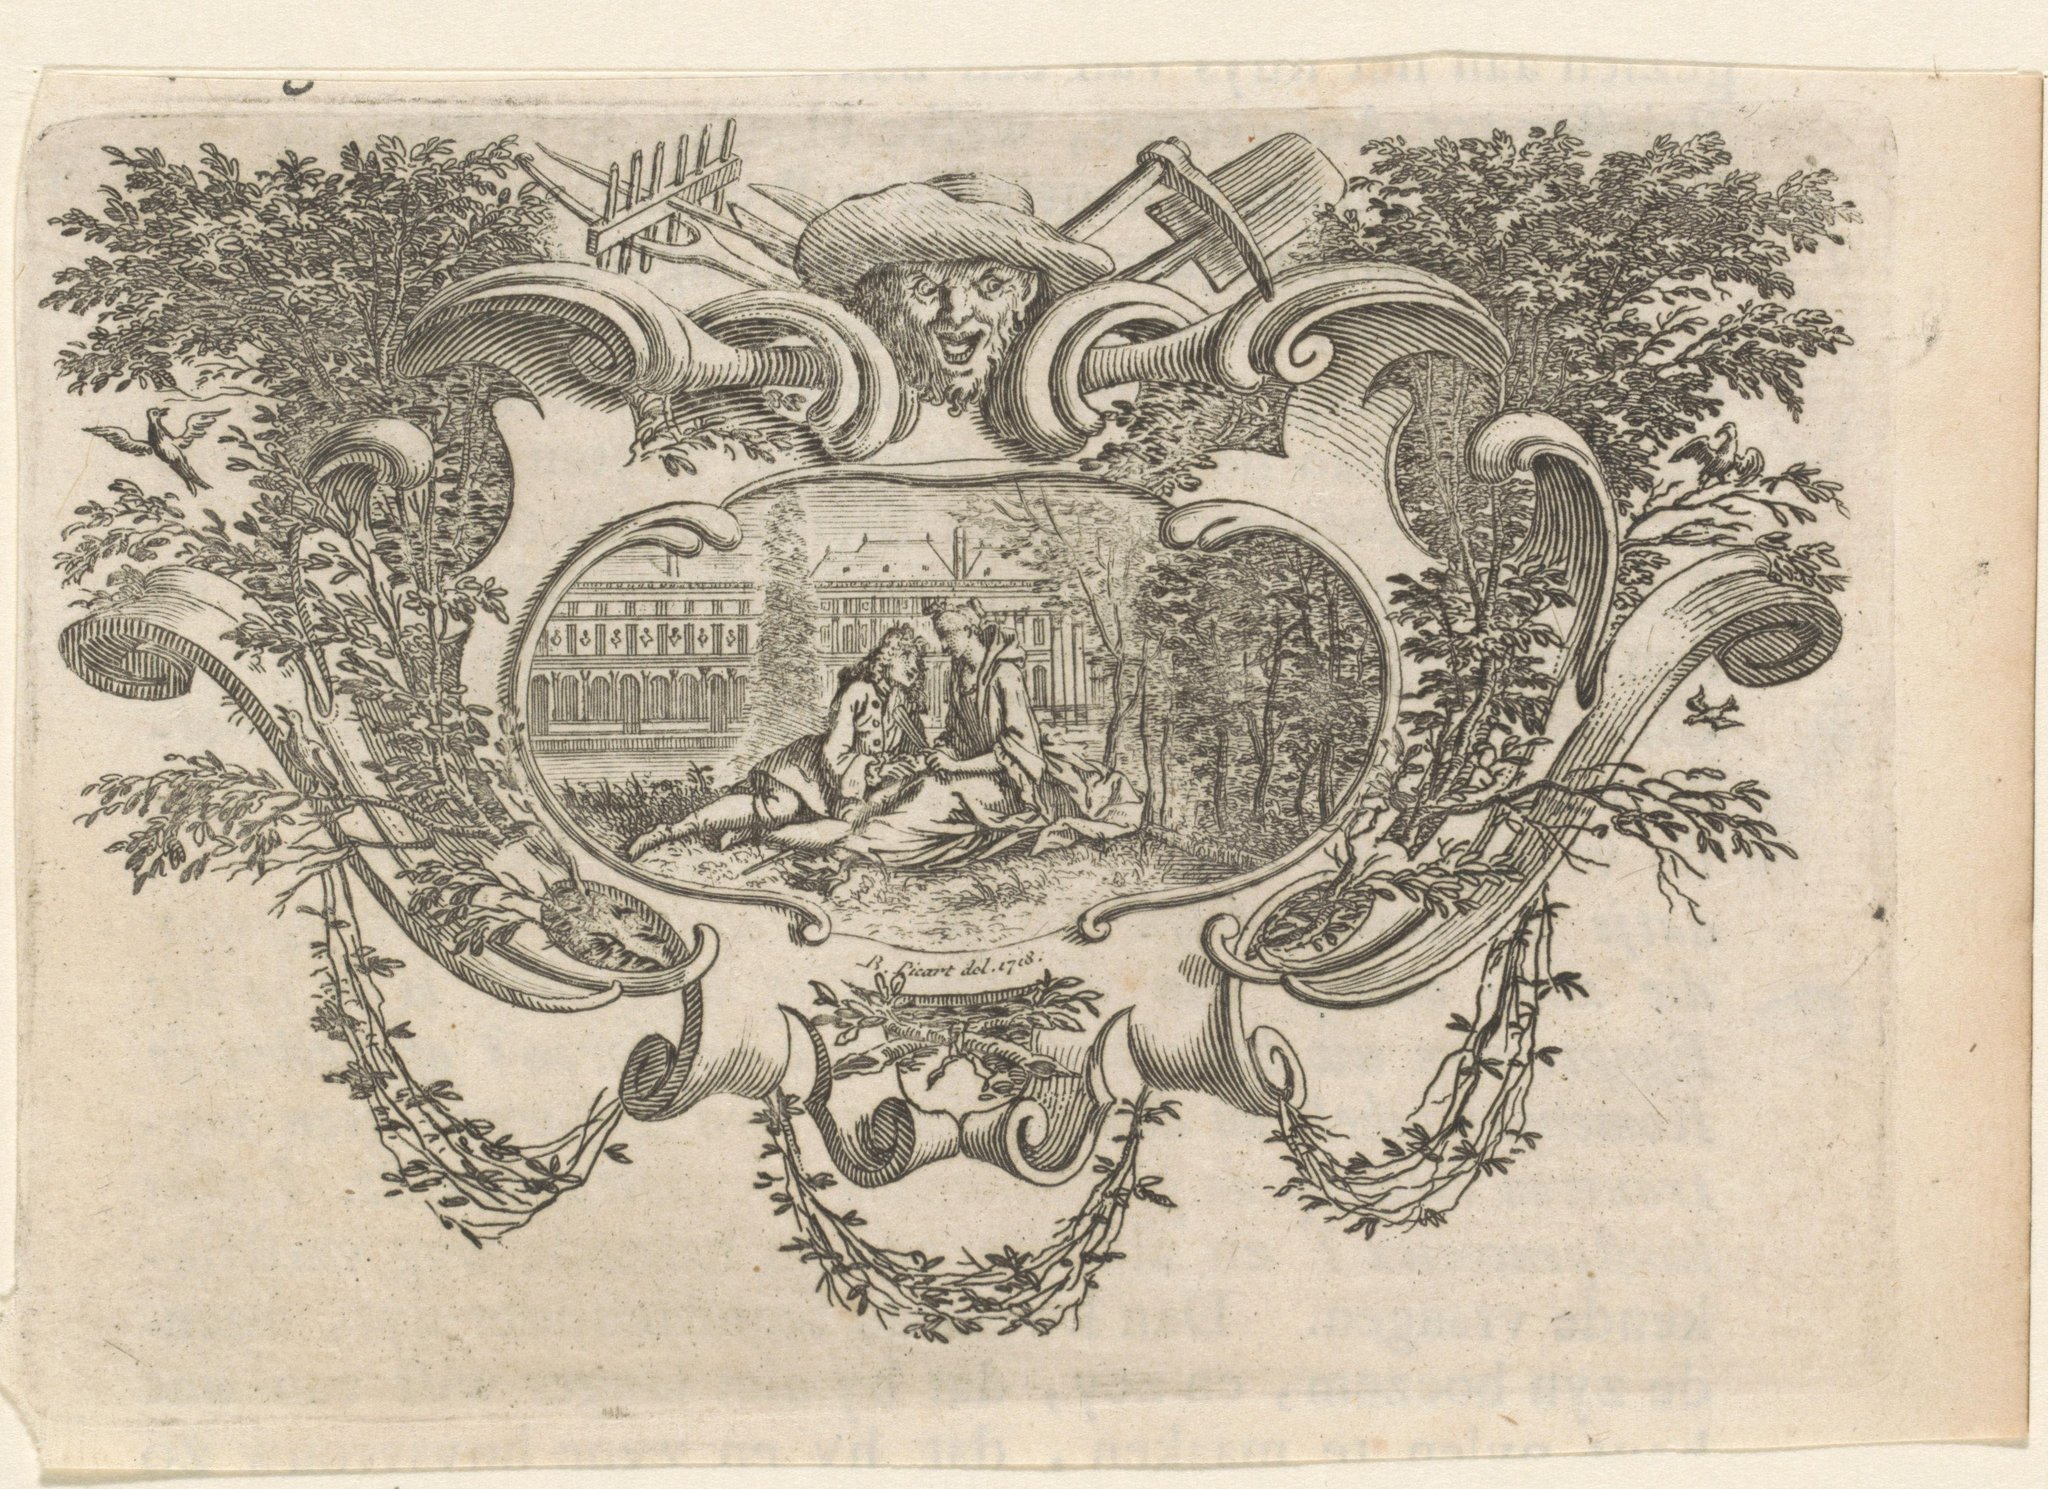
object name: print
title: Liefdespaar in tuin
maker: bernard picart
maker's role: draughtsman, print maker, publisher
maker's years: 1673-1733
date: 1718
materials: paper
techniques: engraving, etching, letterpress printing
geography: amsterdam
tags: ornaments ~ art, garden, lovers; courting, flirting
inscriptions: collector's mark: Lugt 2228, collector's mark: Lugt 2760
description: Een paar zit samen in een tuin. Op de achtergrond een paleis. De voorstelling is gevat in een ornamentele lijst met midden boven het gezicht van een tuinman en tuinwerktuigen.